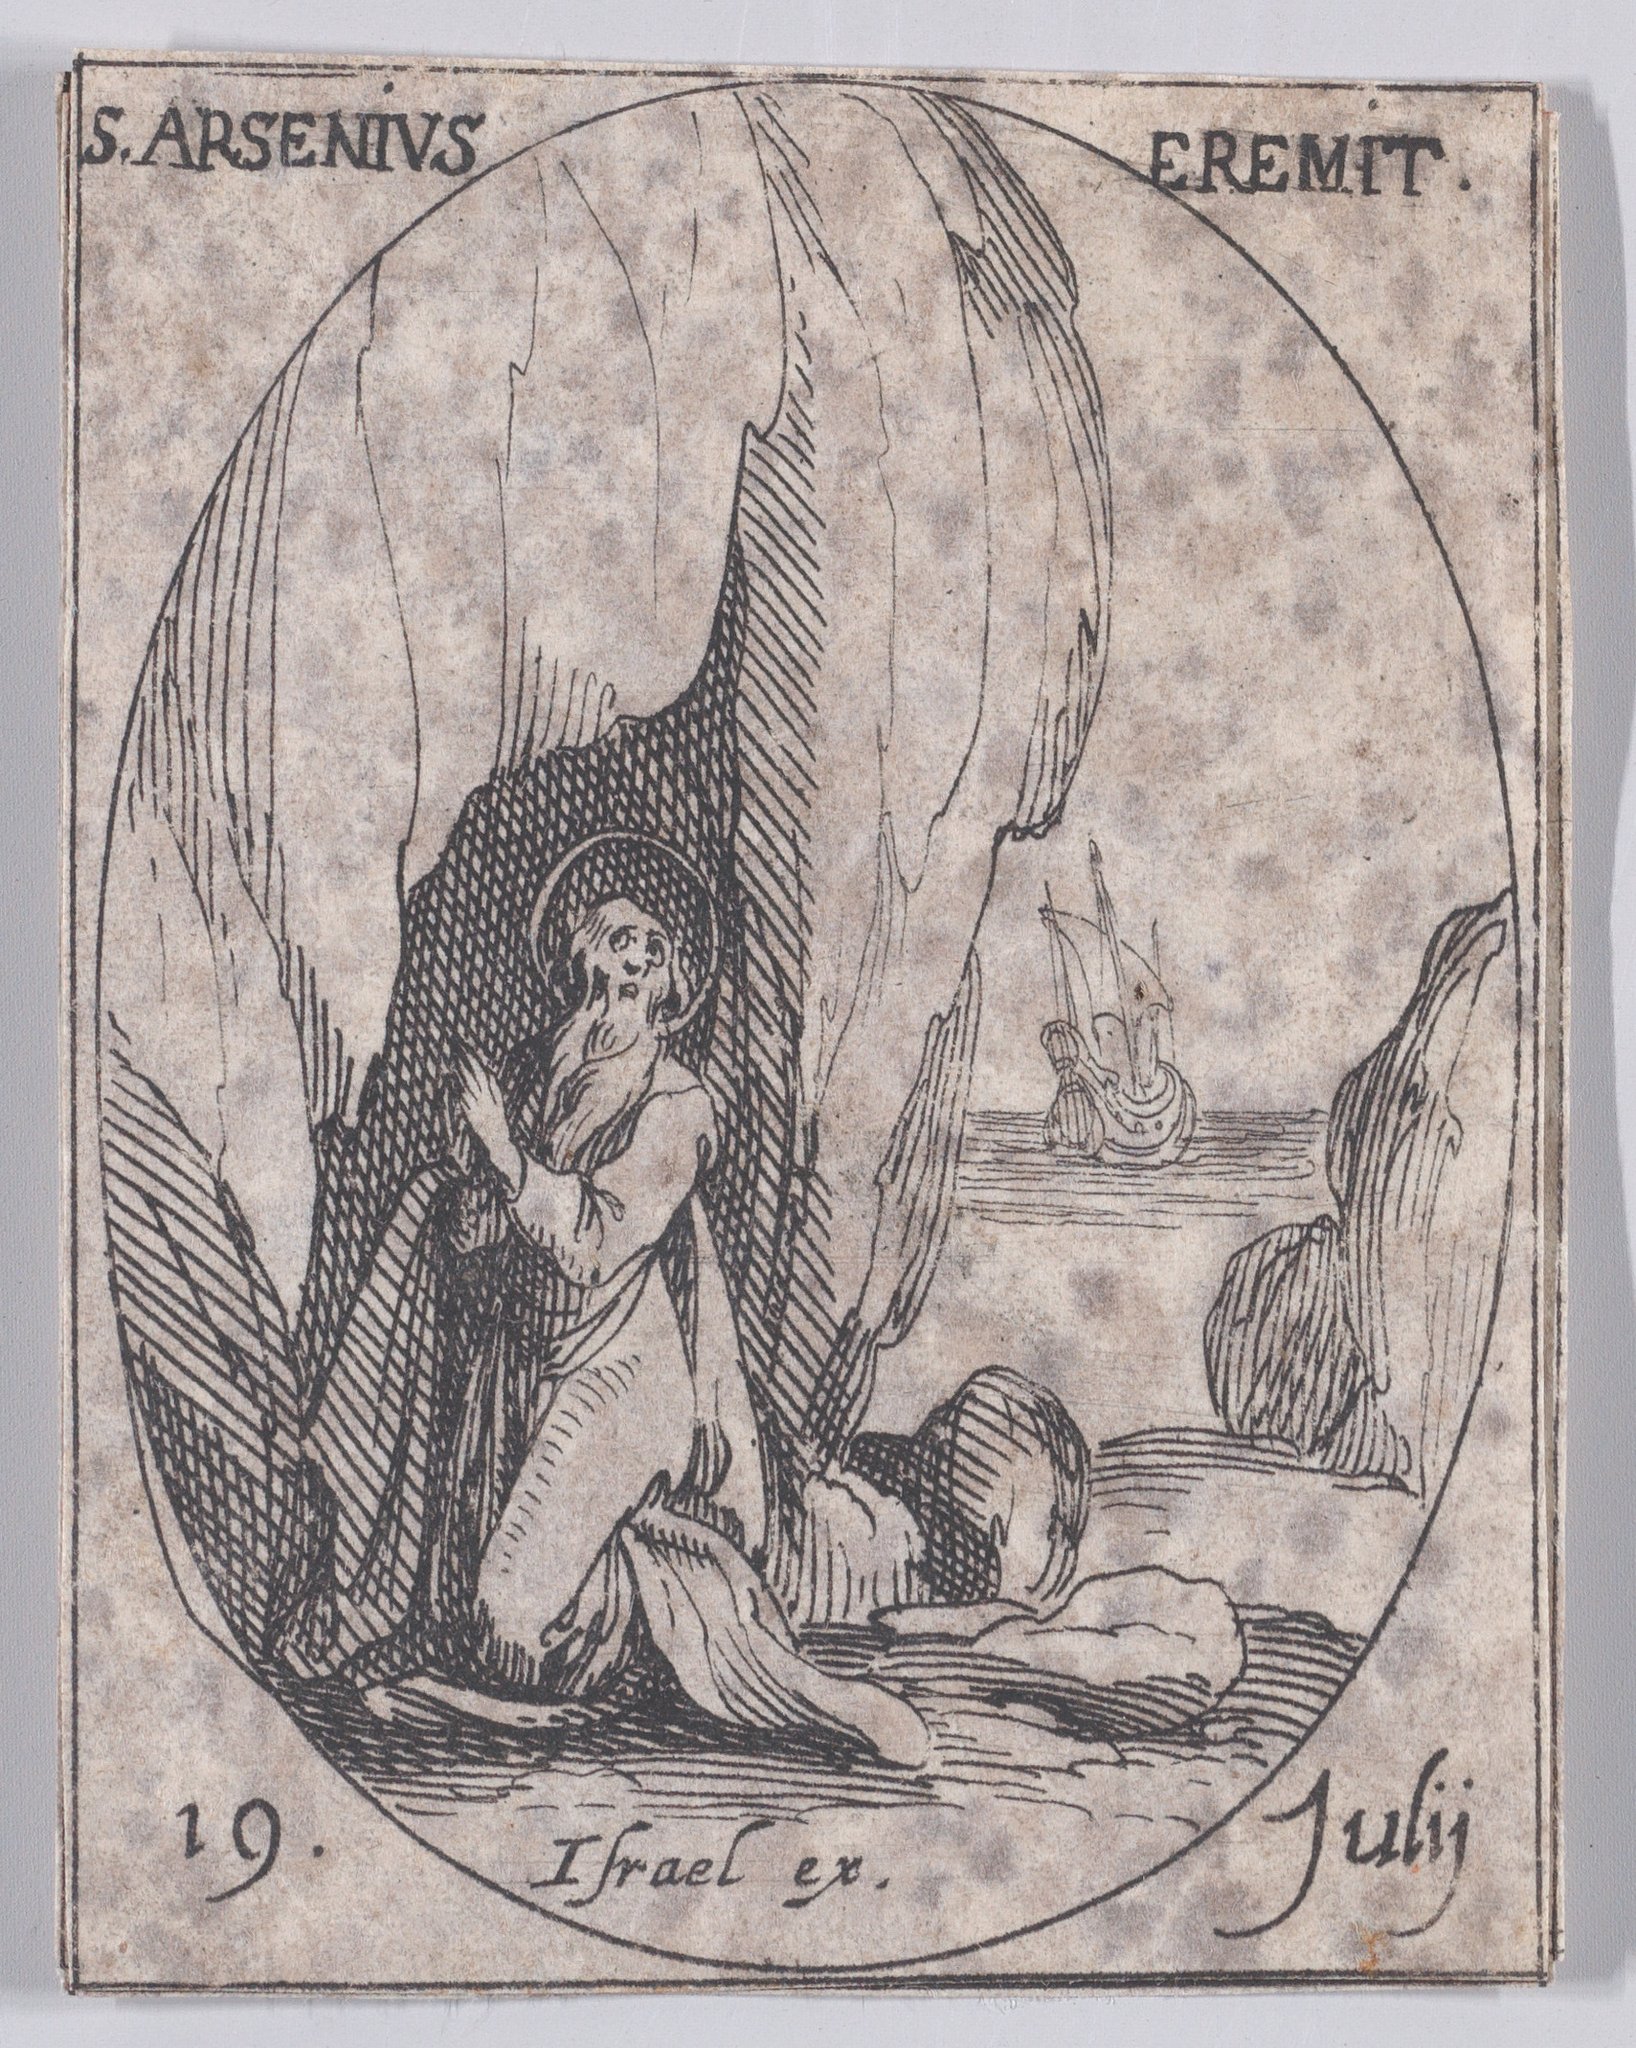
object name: print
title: S. Arsène, ermite (St. Arsenius, Hermit), July 19th, from "Les Images De Tous Les Saincts et Saintes de L'Année" (Images of All of the Saints and Religious Events of the Year)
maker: jacques callot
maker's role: artist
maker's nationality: french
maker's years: 1592-1635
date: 1636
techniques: etching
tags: men,saints